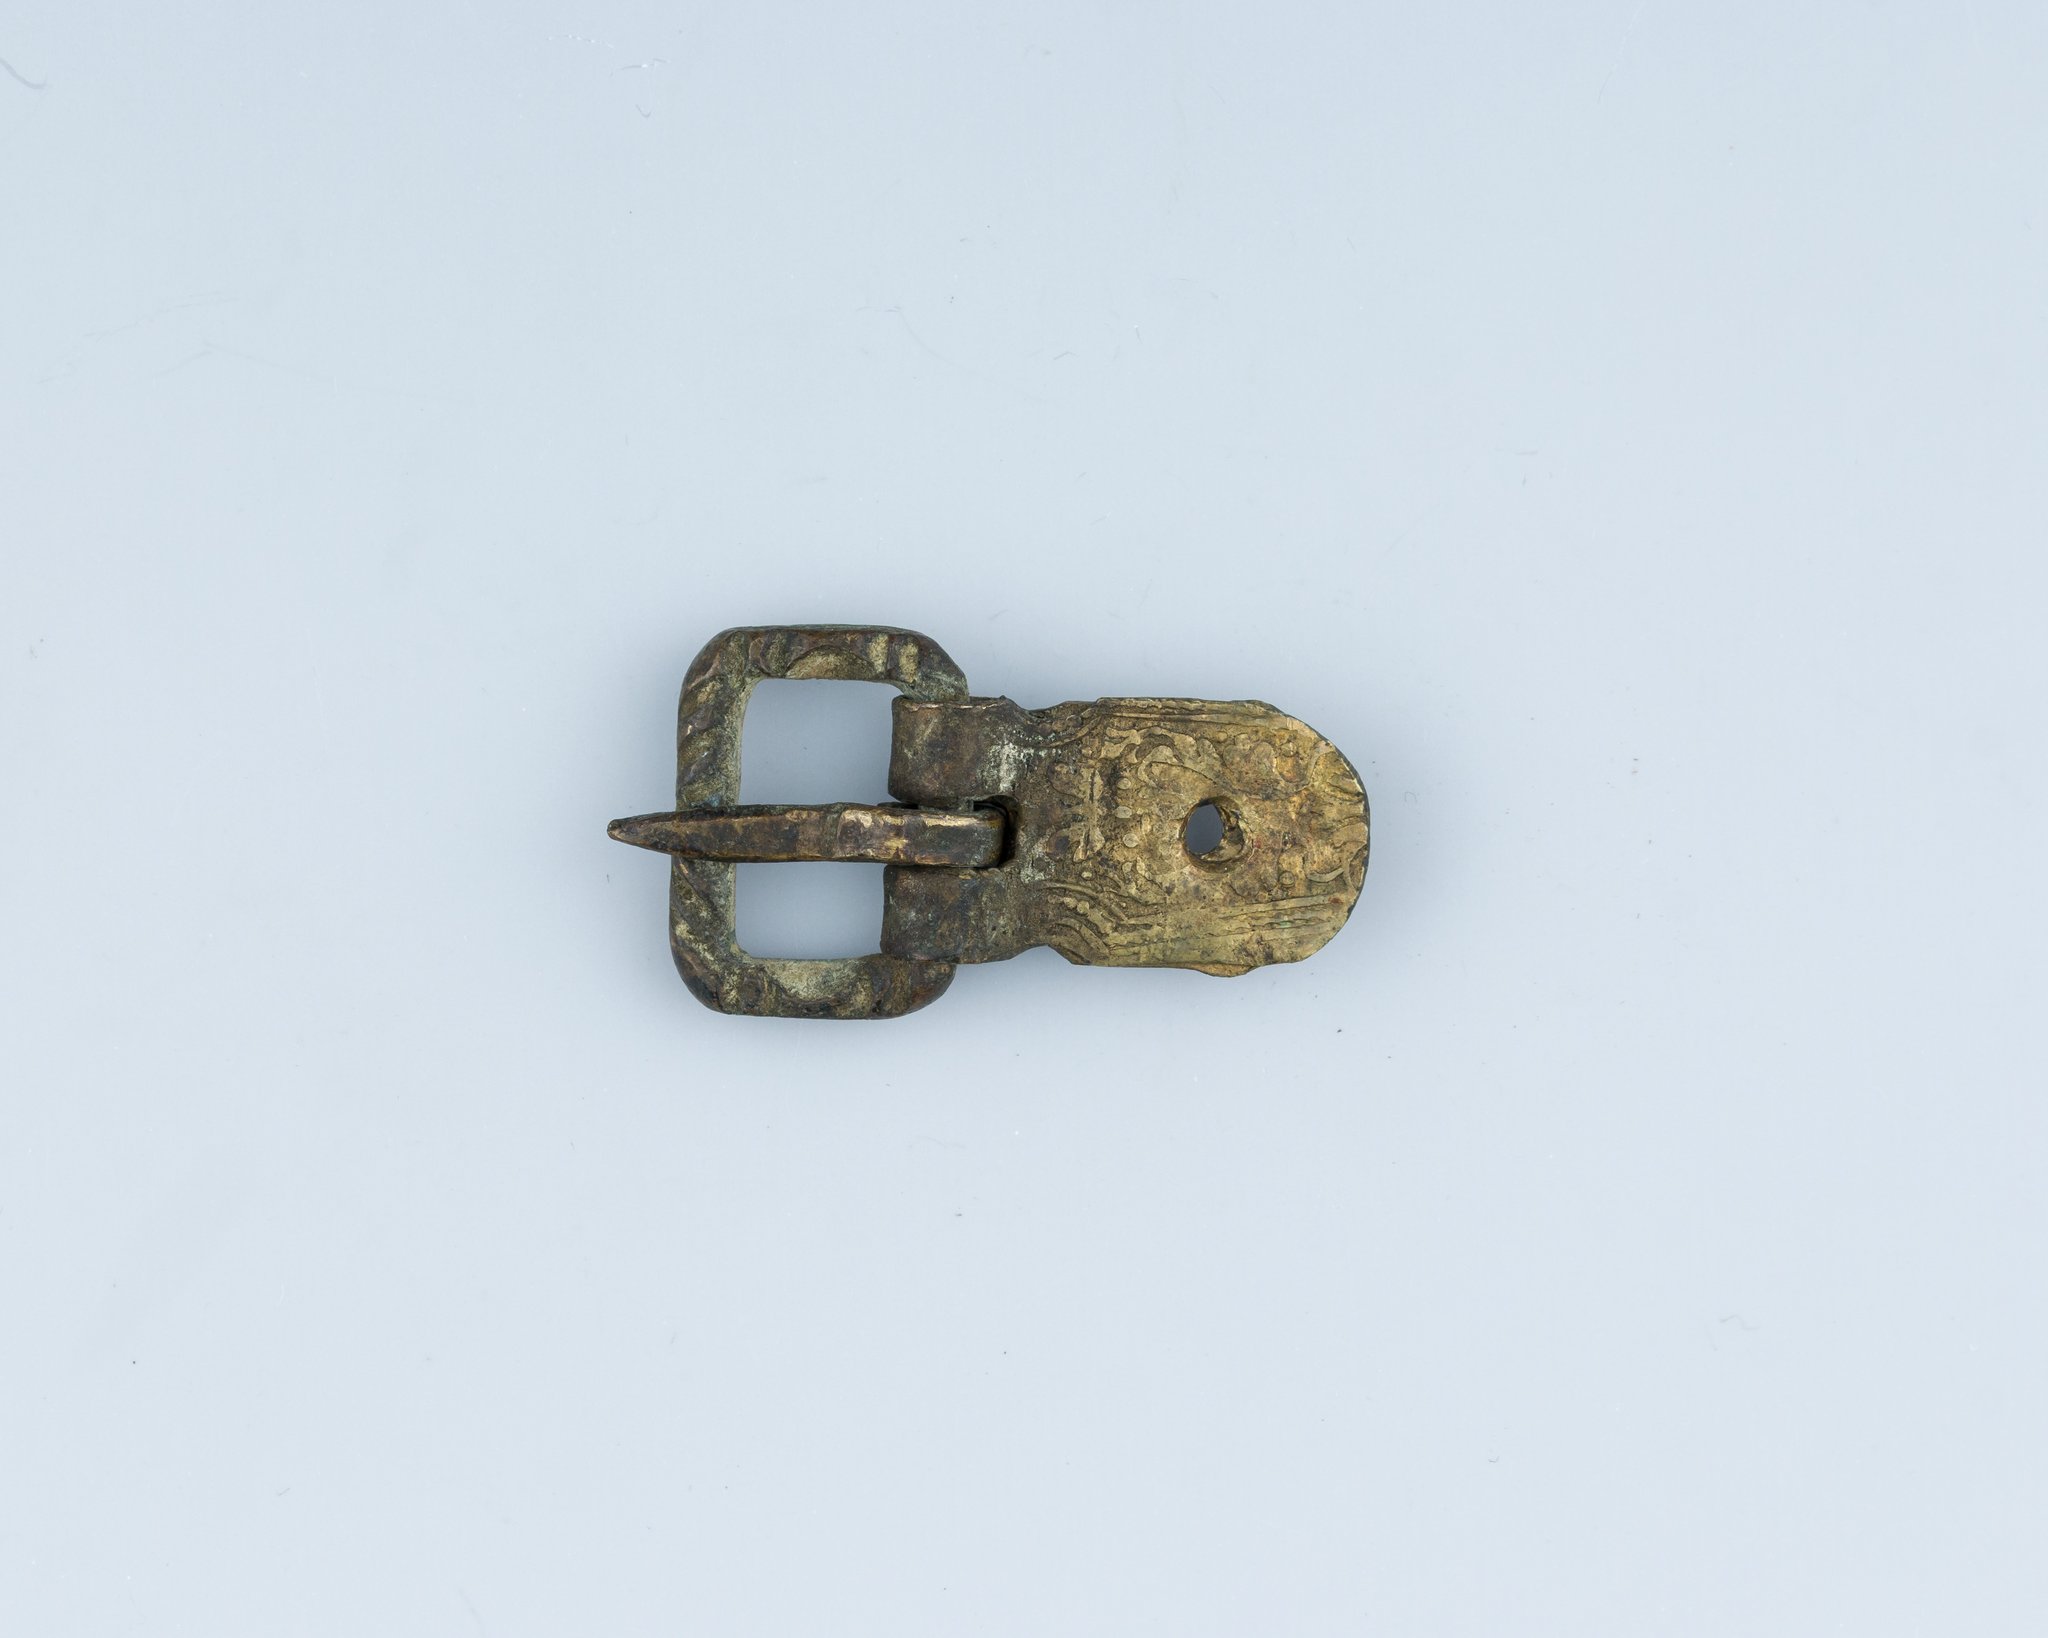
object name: buckle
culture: german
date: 1459-1519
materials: brass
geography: germany